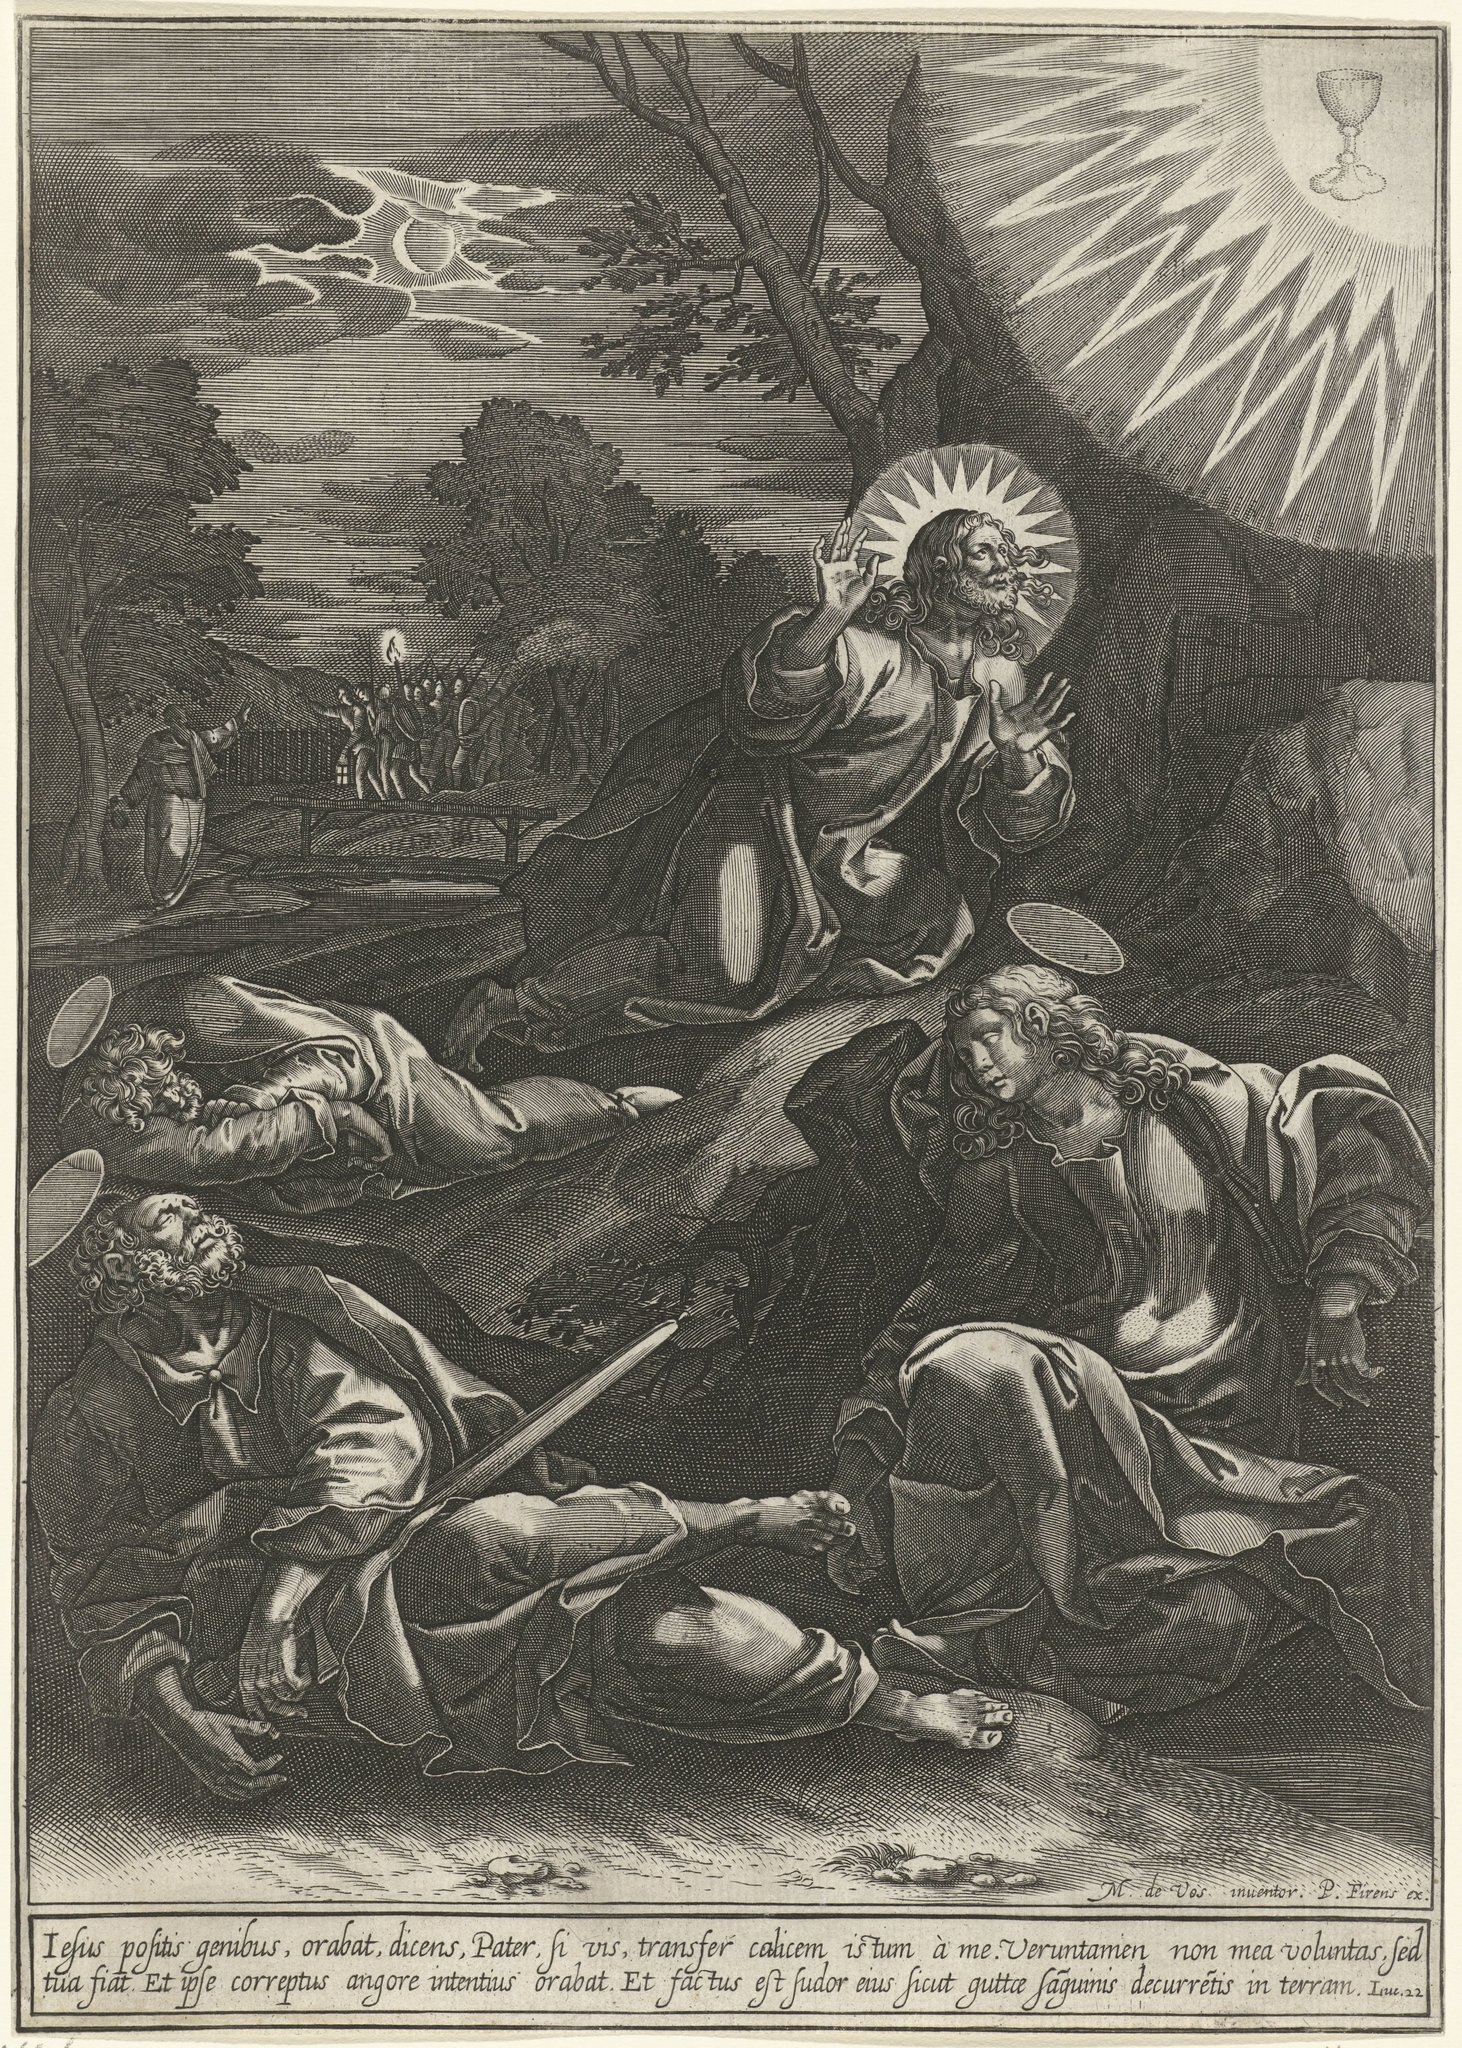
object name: print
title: Passio et Resurrectio D.N. Iesu Christi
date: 1590-1638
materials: paper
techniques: engraving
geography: antwerp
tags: christ's prayer in the garden of gethsemane during the night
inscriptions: collector's mark: Lugt 2760, collector's mark: Lugt 2228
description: De biddende Christus en de slapende apostelen in de tuin van Getsemane. In de rechterbovenhoek een visioen met een lichtgevende kelk. Op de achtergrond komt Judas met de soldaten Getsemane binnen. De prent heeft een Latijns onderschrift met een tekst uit de Bijbel en is de tweede prent van een veertiendelige serie over de passie van Christus.